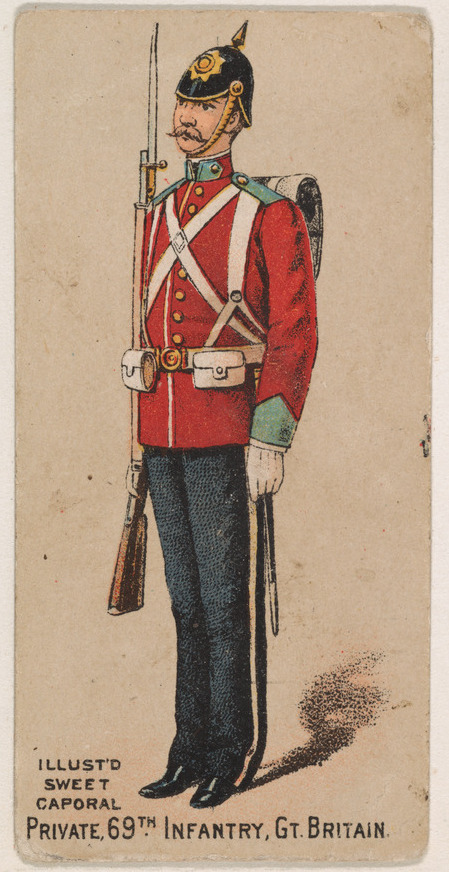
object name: print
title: Private, 69th Infantry, Great Britain, from the Military Series (N224) issued by Kinney Tobacco Company to promote Sweet Caporal Cigarettes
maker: kinney brothers tobacco company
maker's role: publisher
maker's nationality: american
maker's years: 1869-2011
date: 1888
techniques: color lithograph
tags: military,men